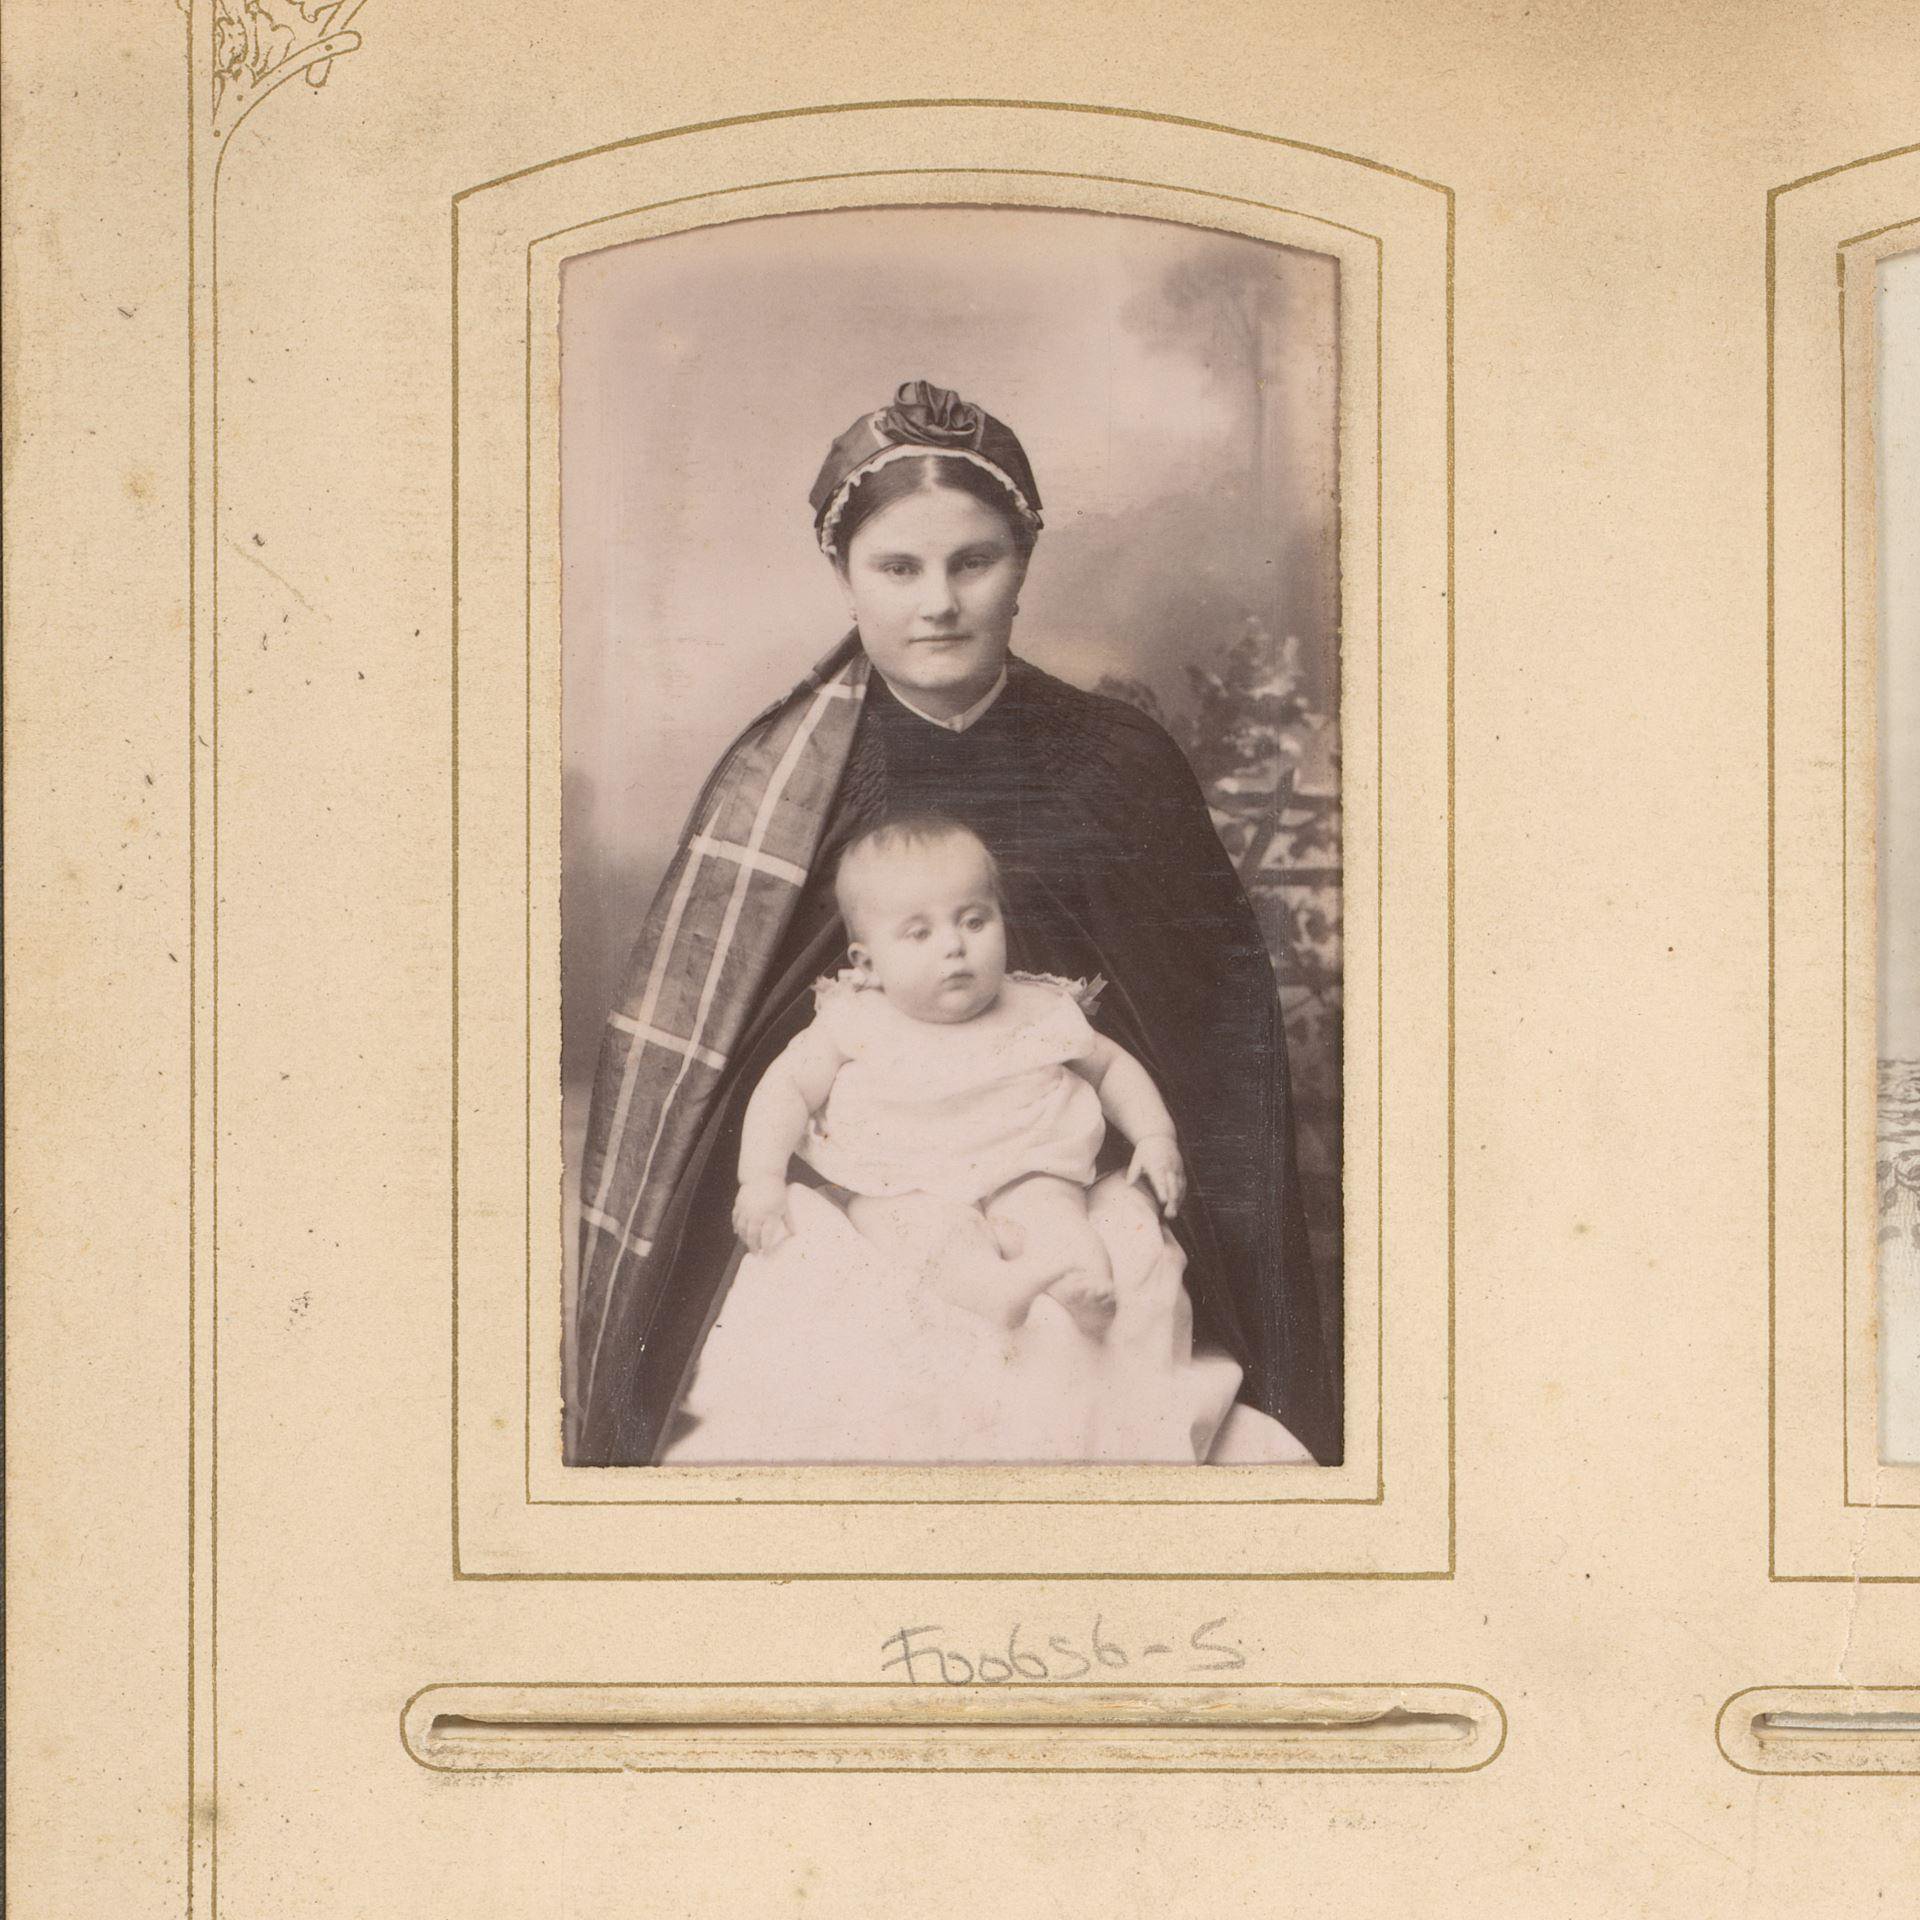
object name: semi enamel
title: Portret van een vrouw met een baby op schoot, aangeduid als Nelly Merten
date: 1880-1900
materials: cardboard, celluloid, photographic support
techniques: albumen print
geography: ghent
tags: historical persons - bb - woman, infant, baby ~ the ages of man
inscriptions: name: ‘Nelly Merten’, inscription: ‘Photographie/ Cles. de Trez & Cie./ 3 Rue de la Corne, 3/ GAND/ Maison/ a/ BRUGES/ Rue Notre Dame, 14/ Maison/ a/ BRUXELLES/ Rue du Pont neuf, No. 1/ Maison a ANVERS/ 28, Rue du Vallon vert, 28/ 12 Cartes satinée./ Les Clichés sont conservés’